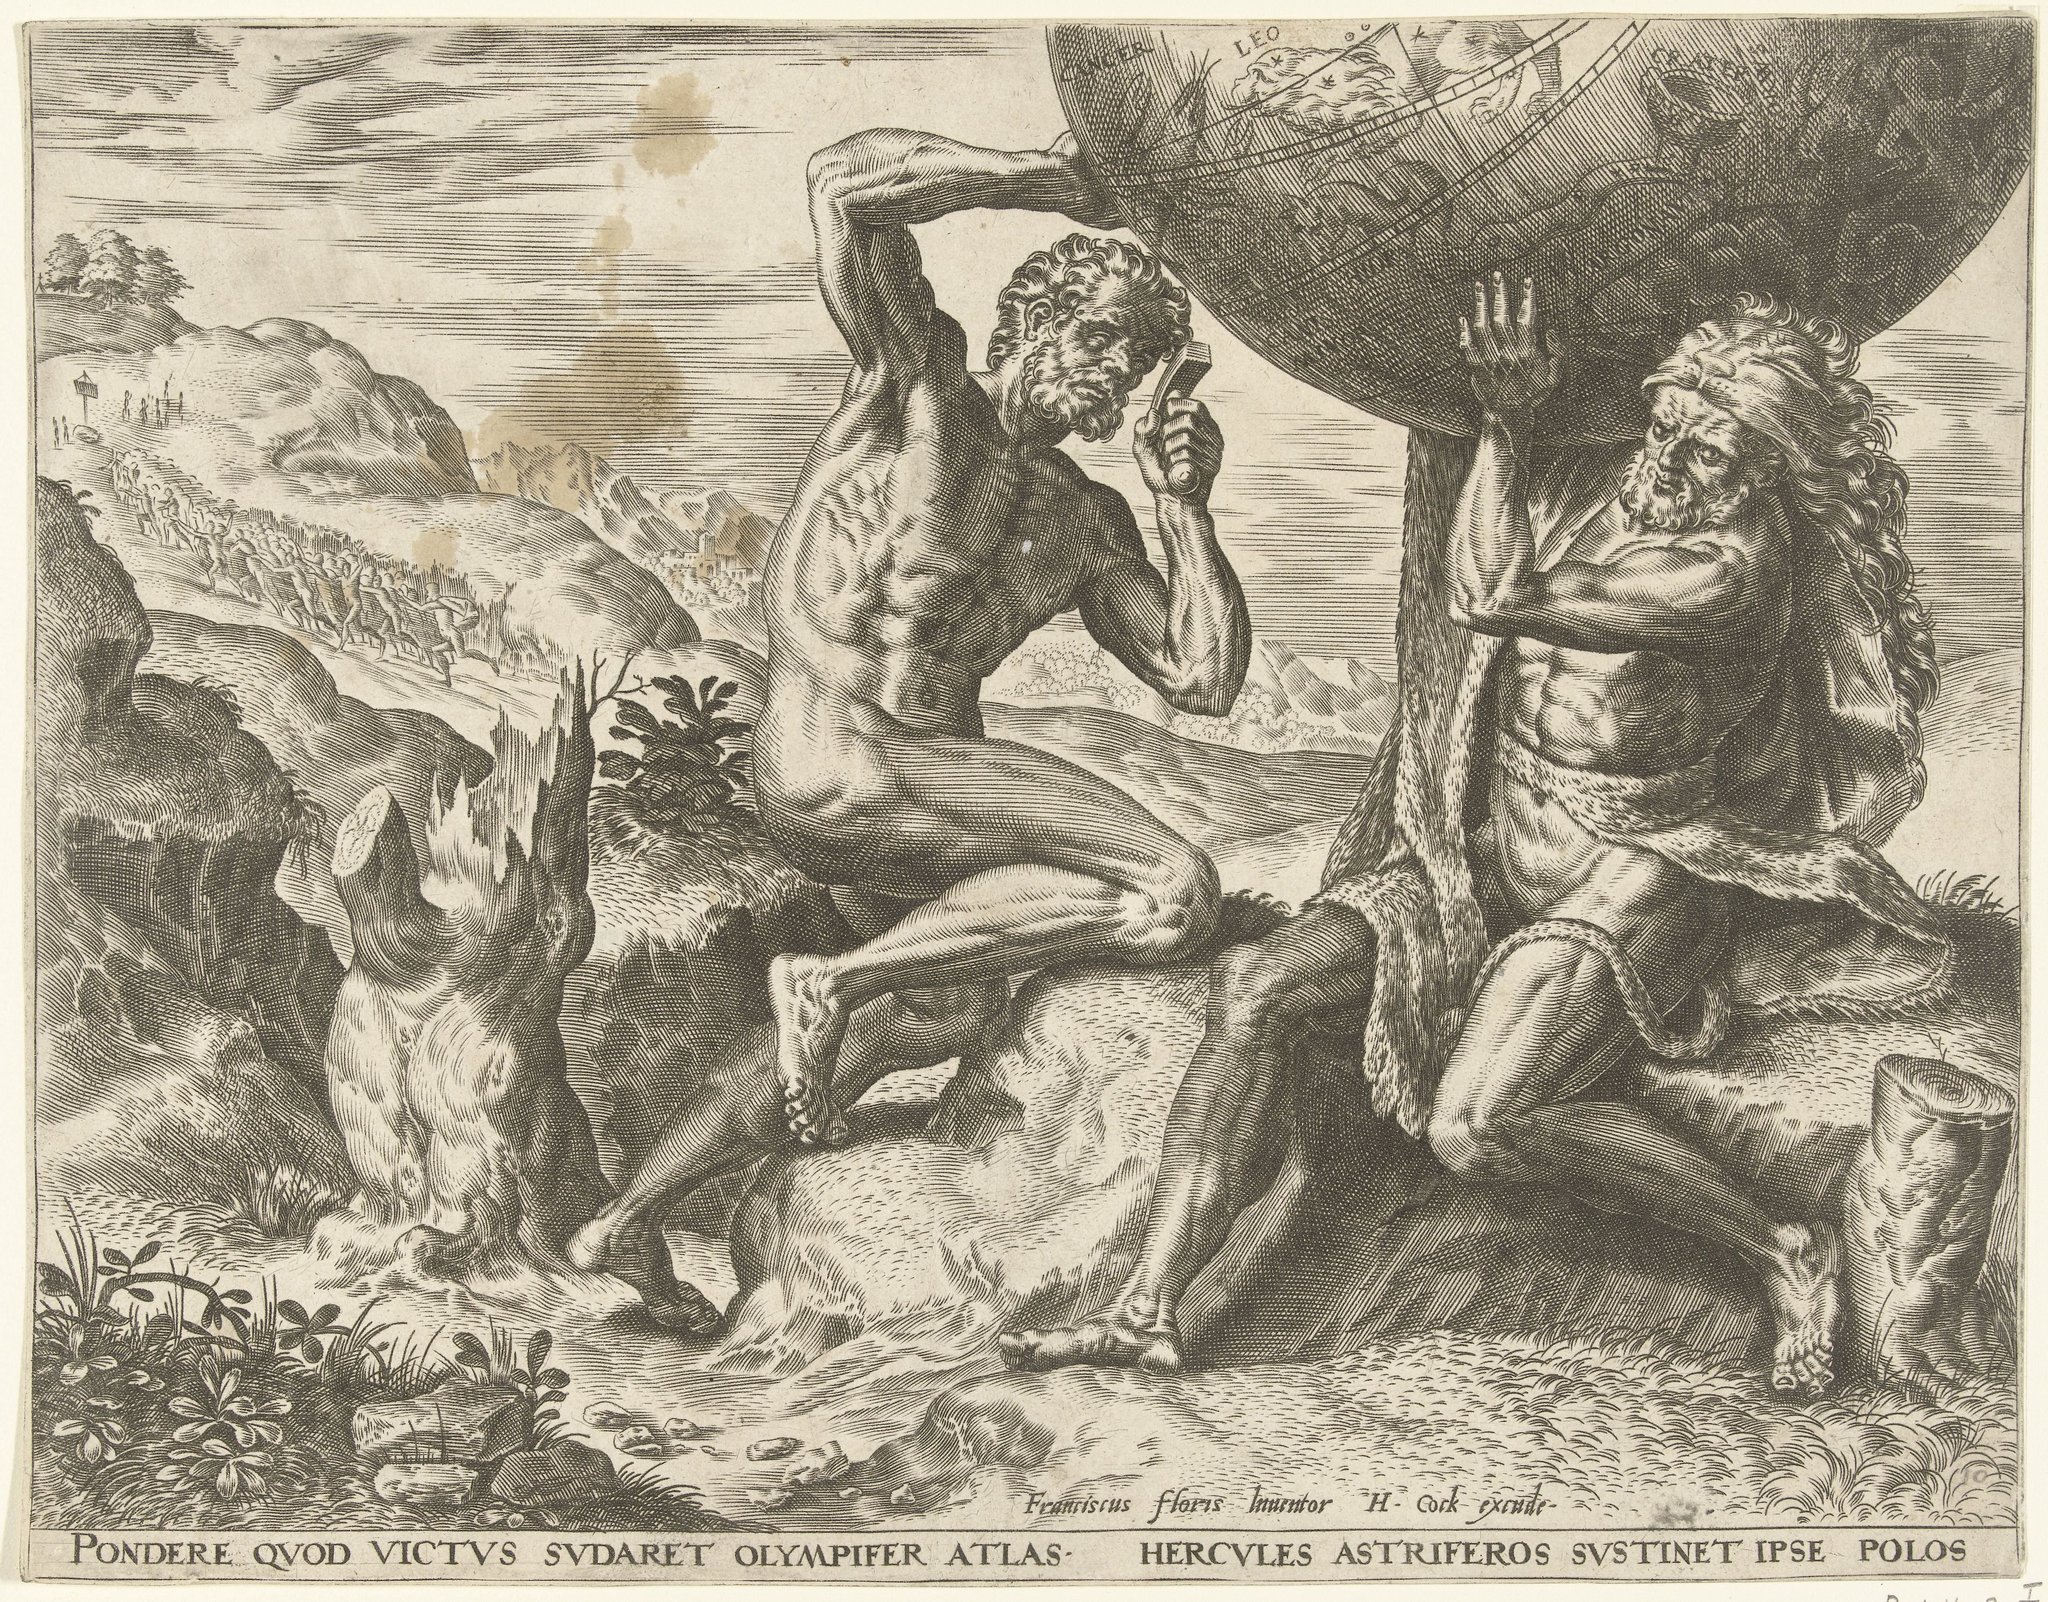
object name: print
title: Hercules torst de wereldbol voor Atlas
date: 1563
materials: paper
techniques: engraving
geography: antwerp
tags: hercules carries the heavens on his shoulders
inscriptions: collector's mark: Lugt 2228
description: Hercules neemt de wereldbol van Atlas over en draagt hem op zijn schouder. Zo kan Atlas voor Hercules de gouden appelen van de Hesperiden stelen.